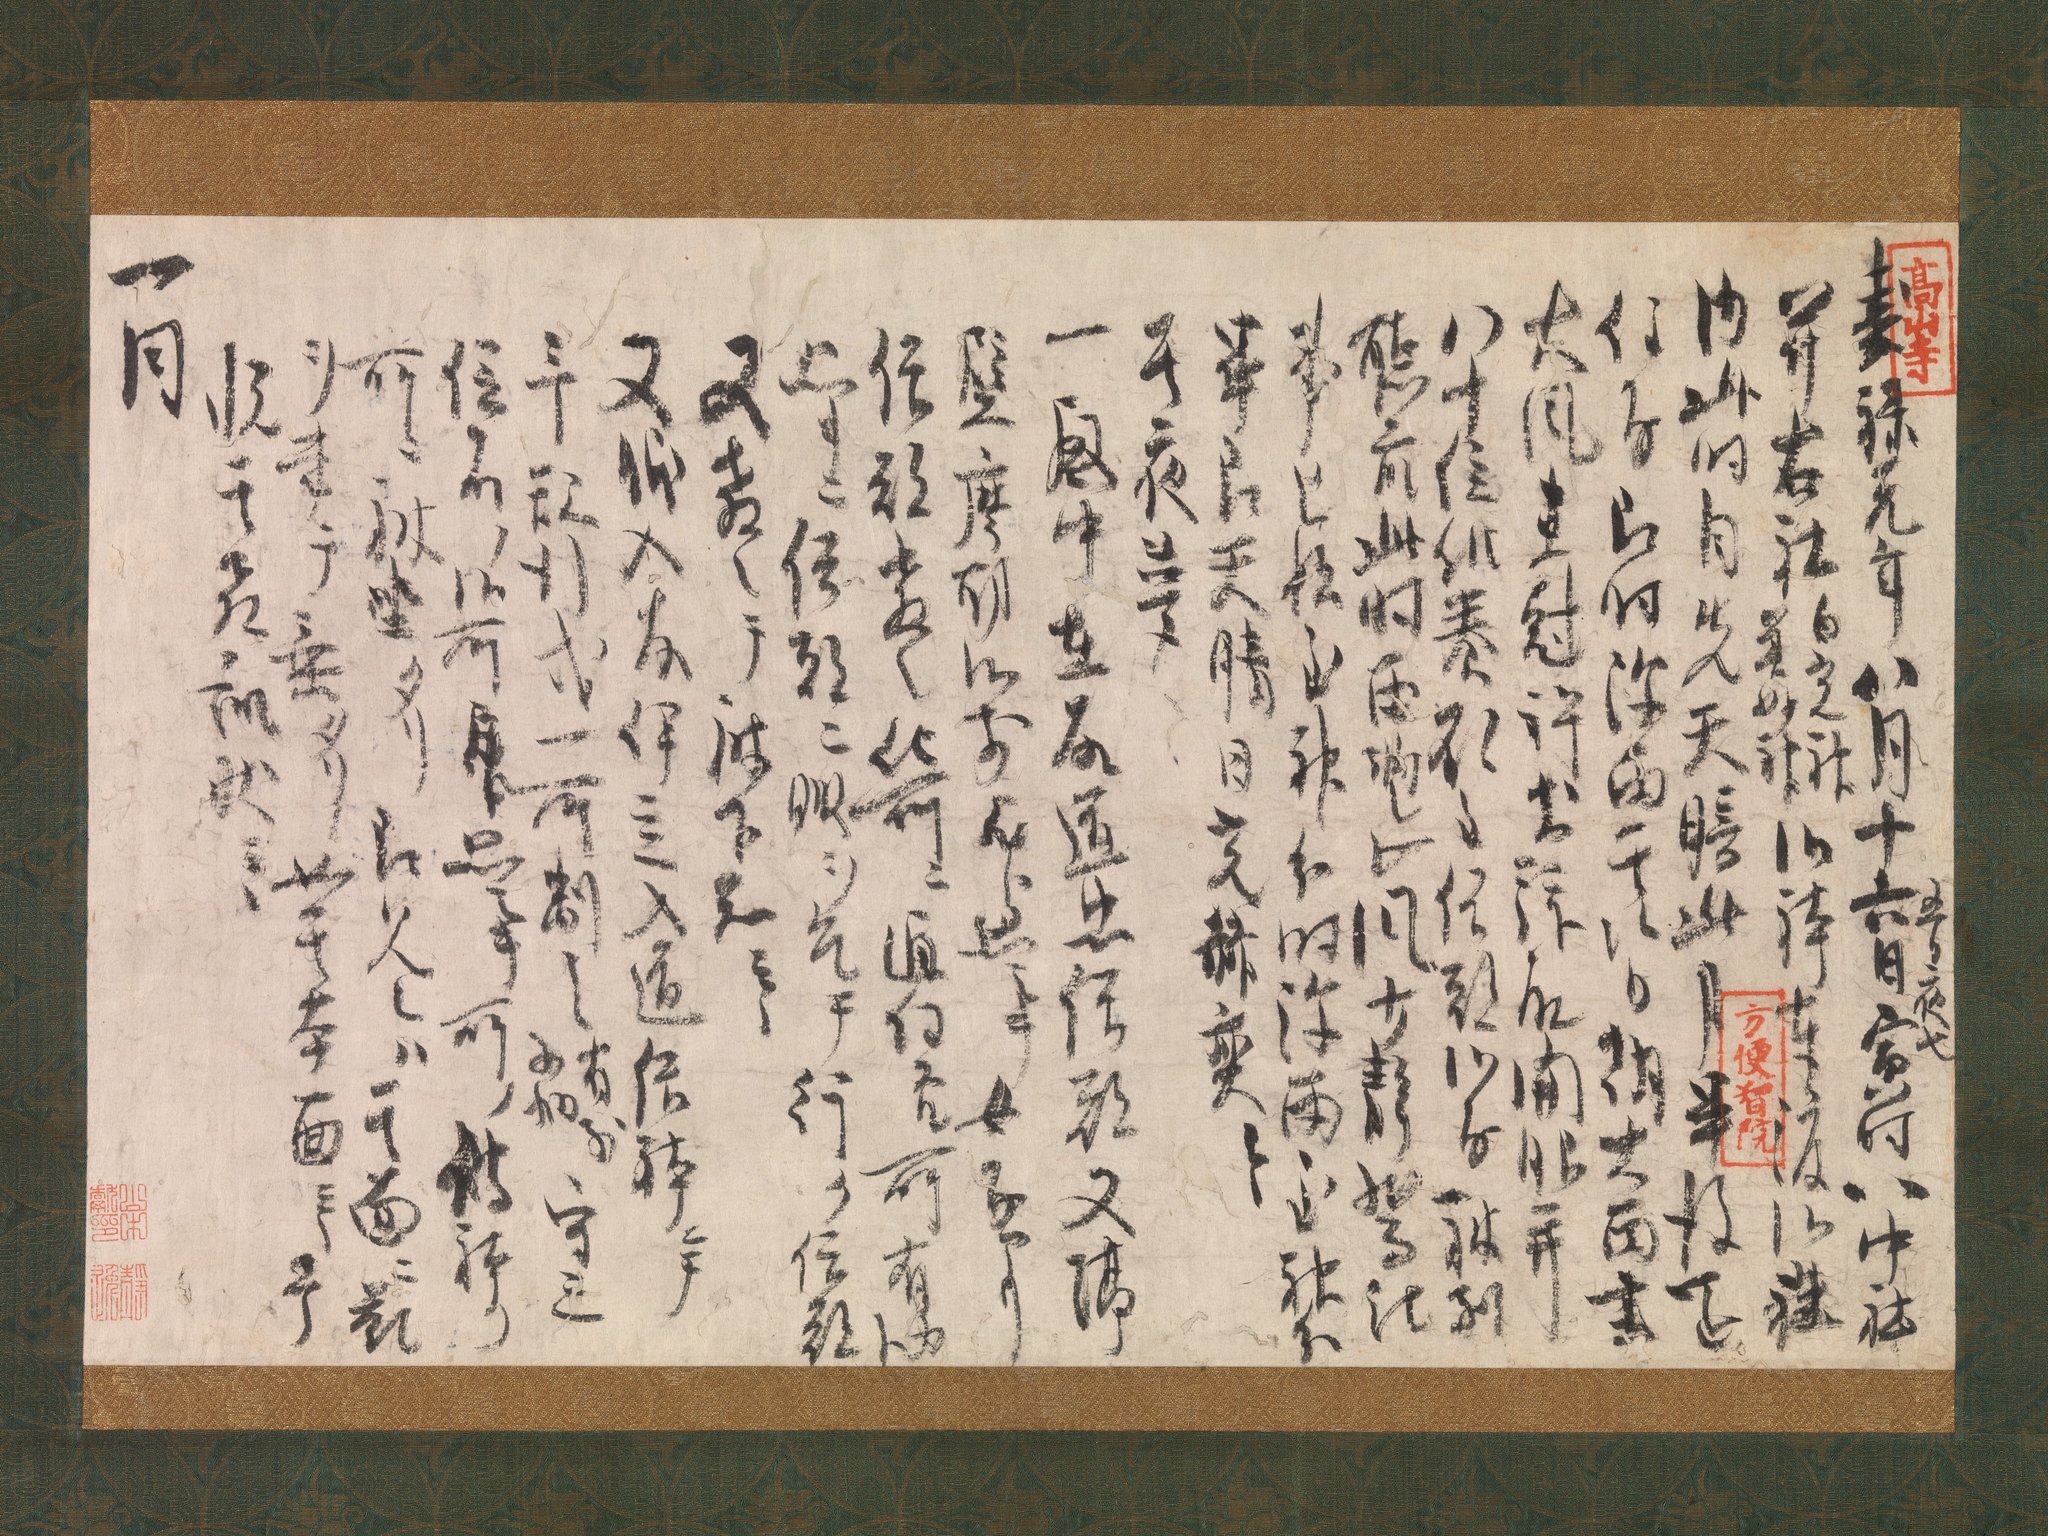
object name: hanging scroll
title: Section of the Dream Diary (Yume no ki)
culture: japanese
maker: myōe kōben 明恵高弁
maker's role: artist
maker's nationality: japanese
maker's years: 1173-1232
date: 1225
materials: ink, paper